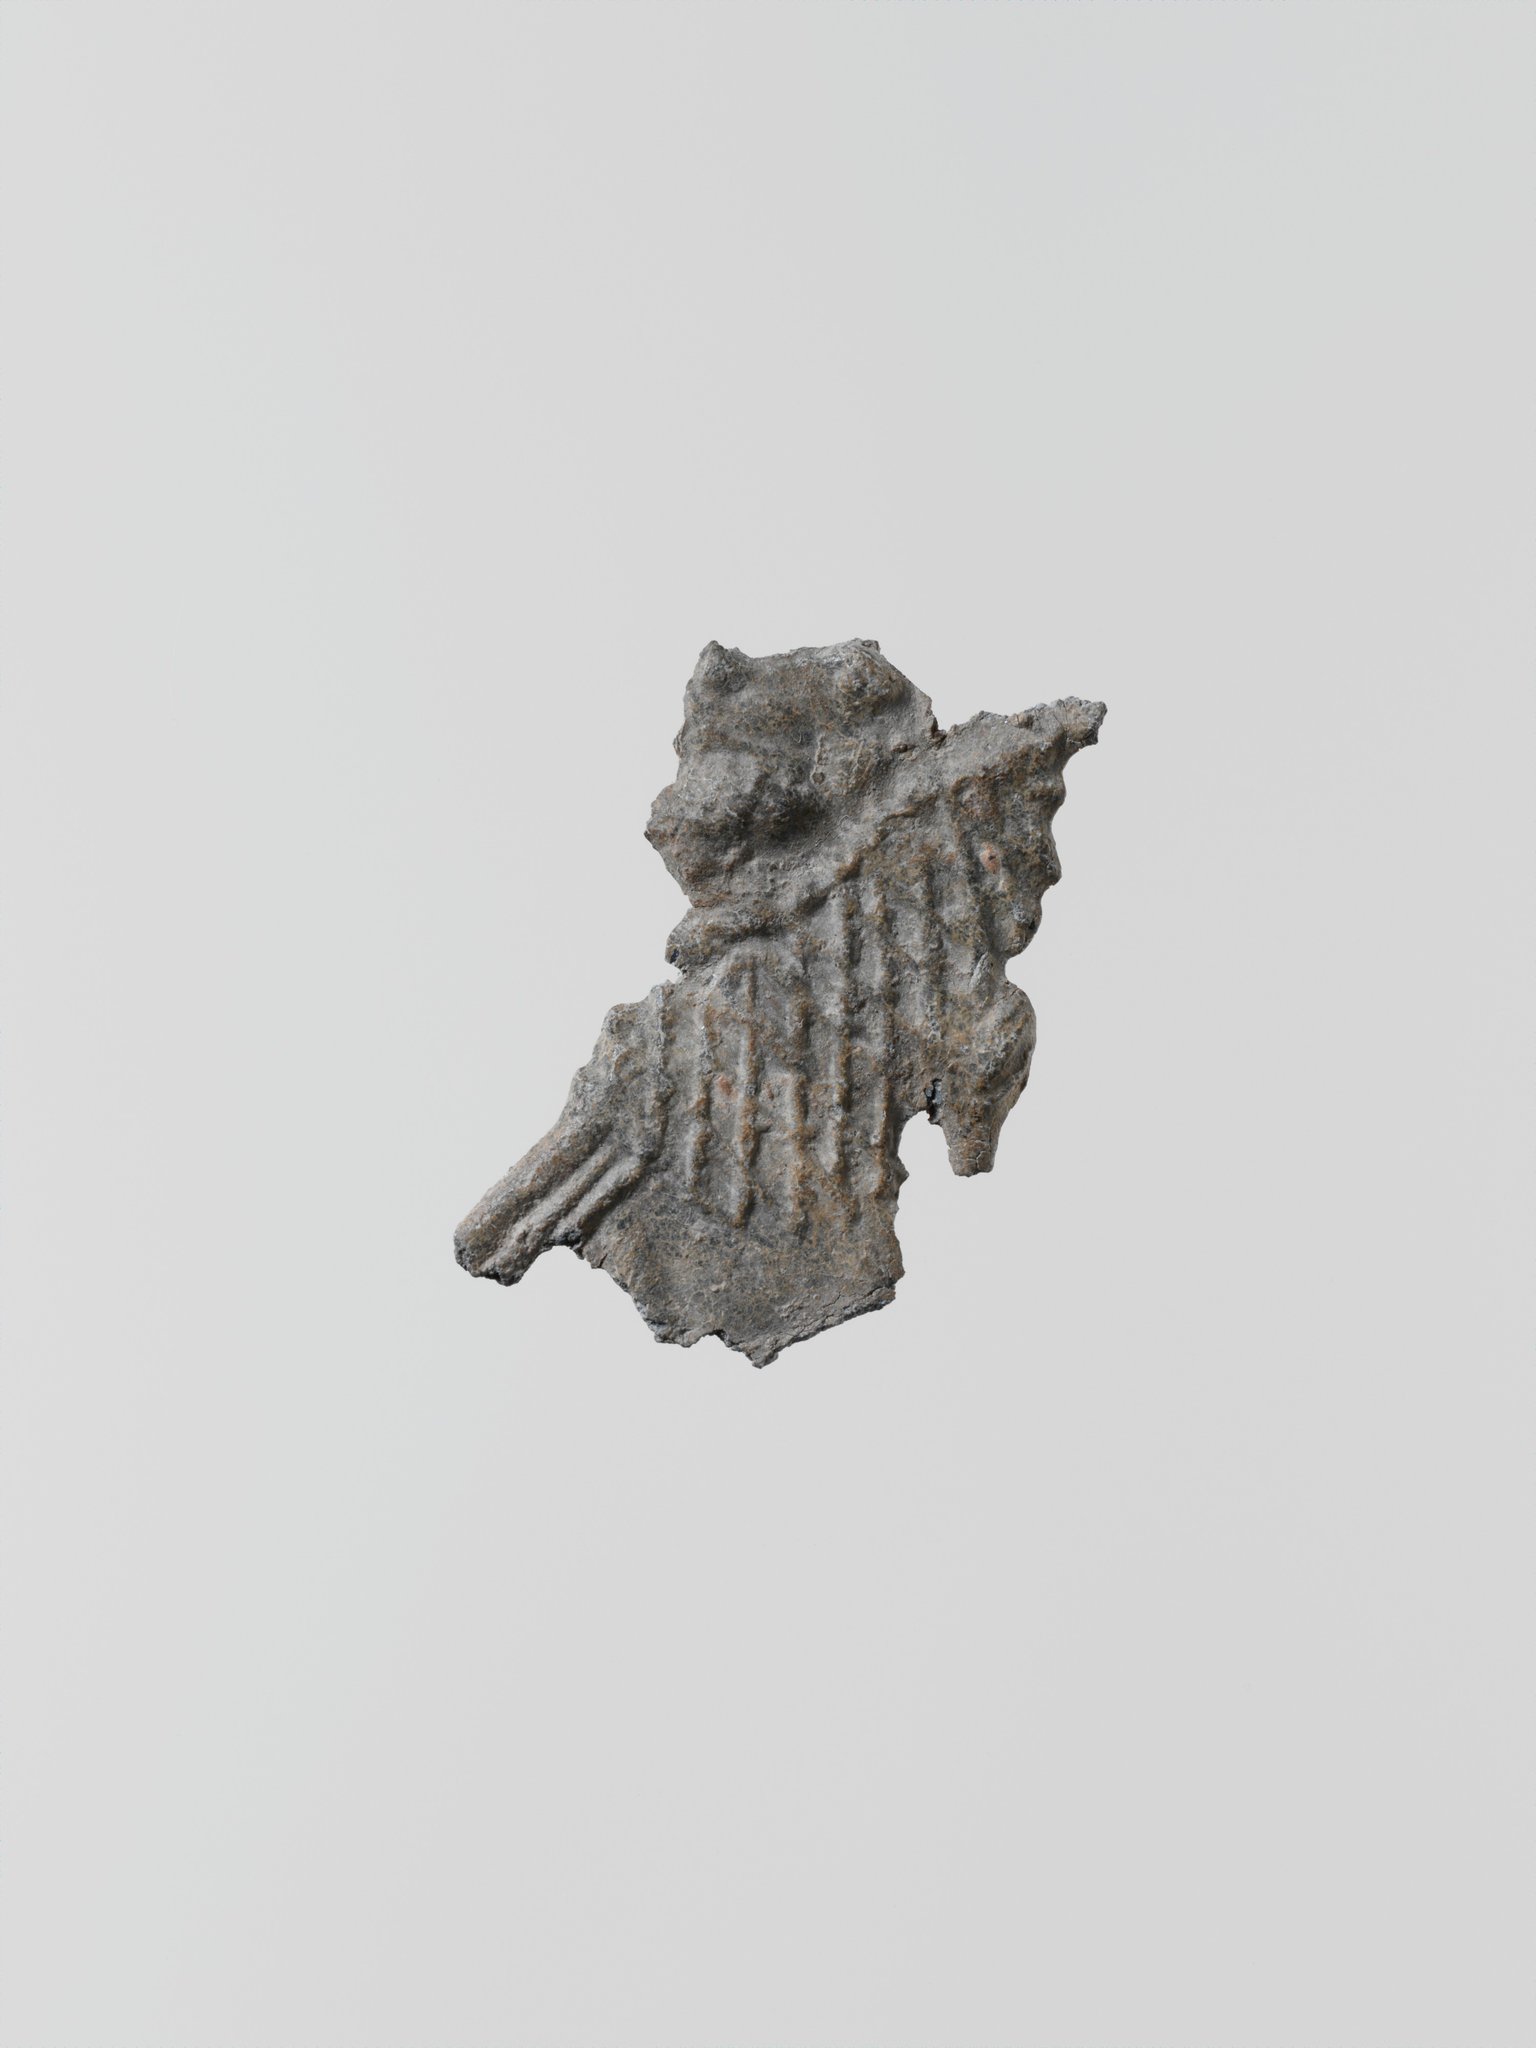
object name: statuette of a lion, 3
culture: greek, laconian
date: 7000-30 BCE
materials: lead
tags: lions